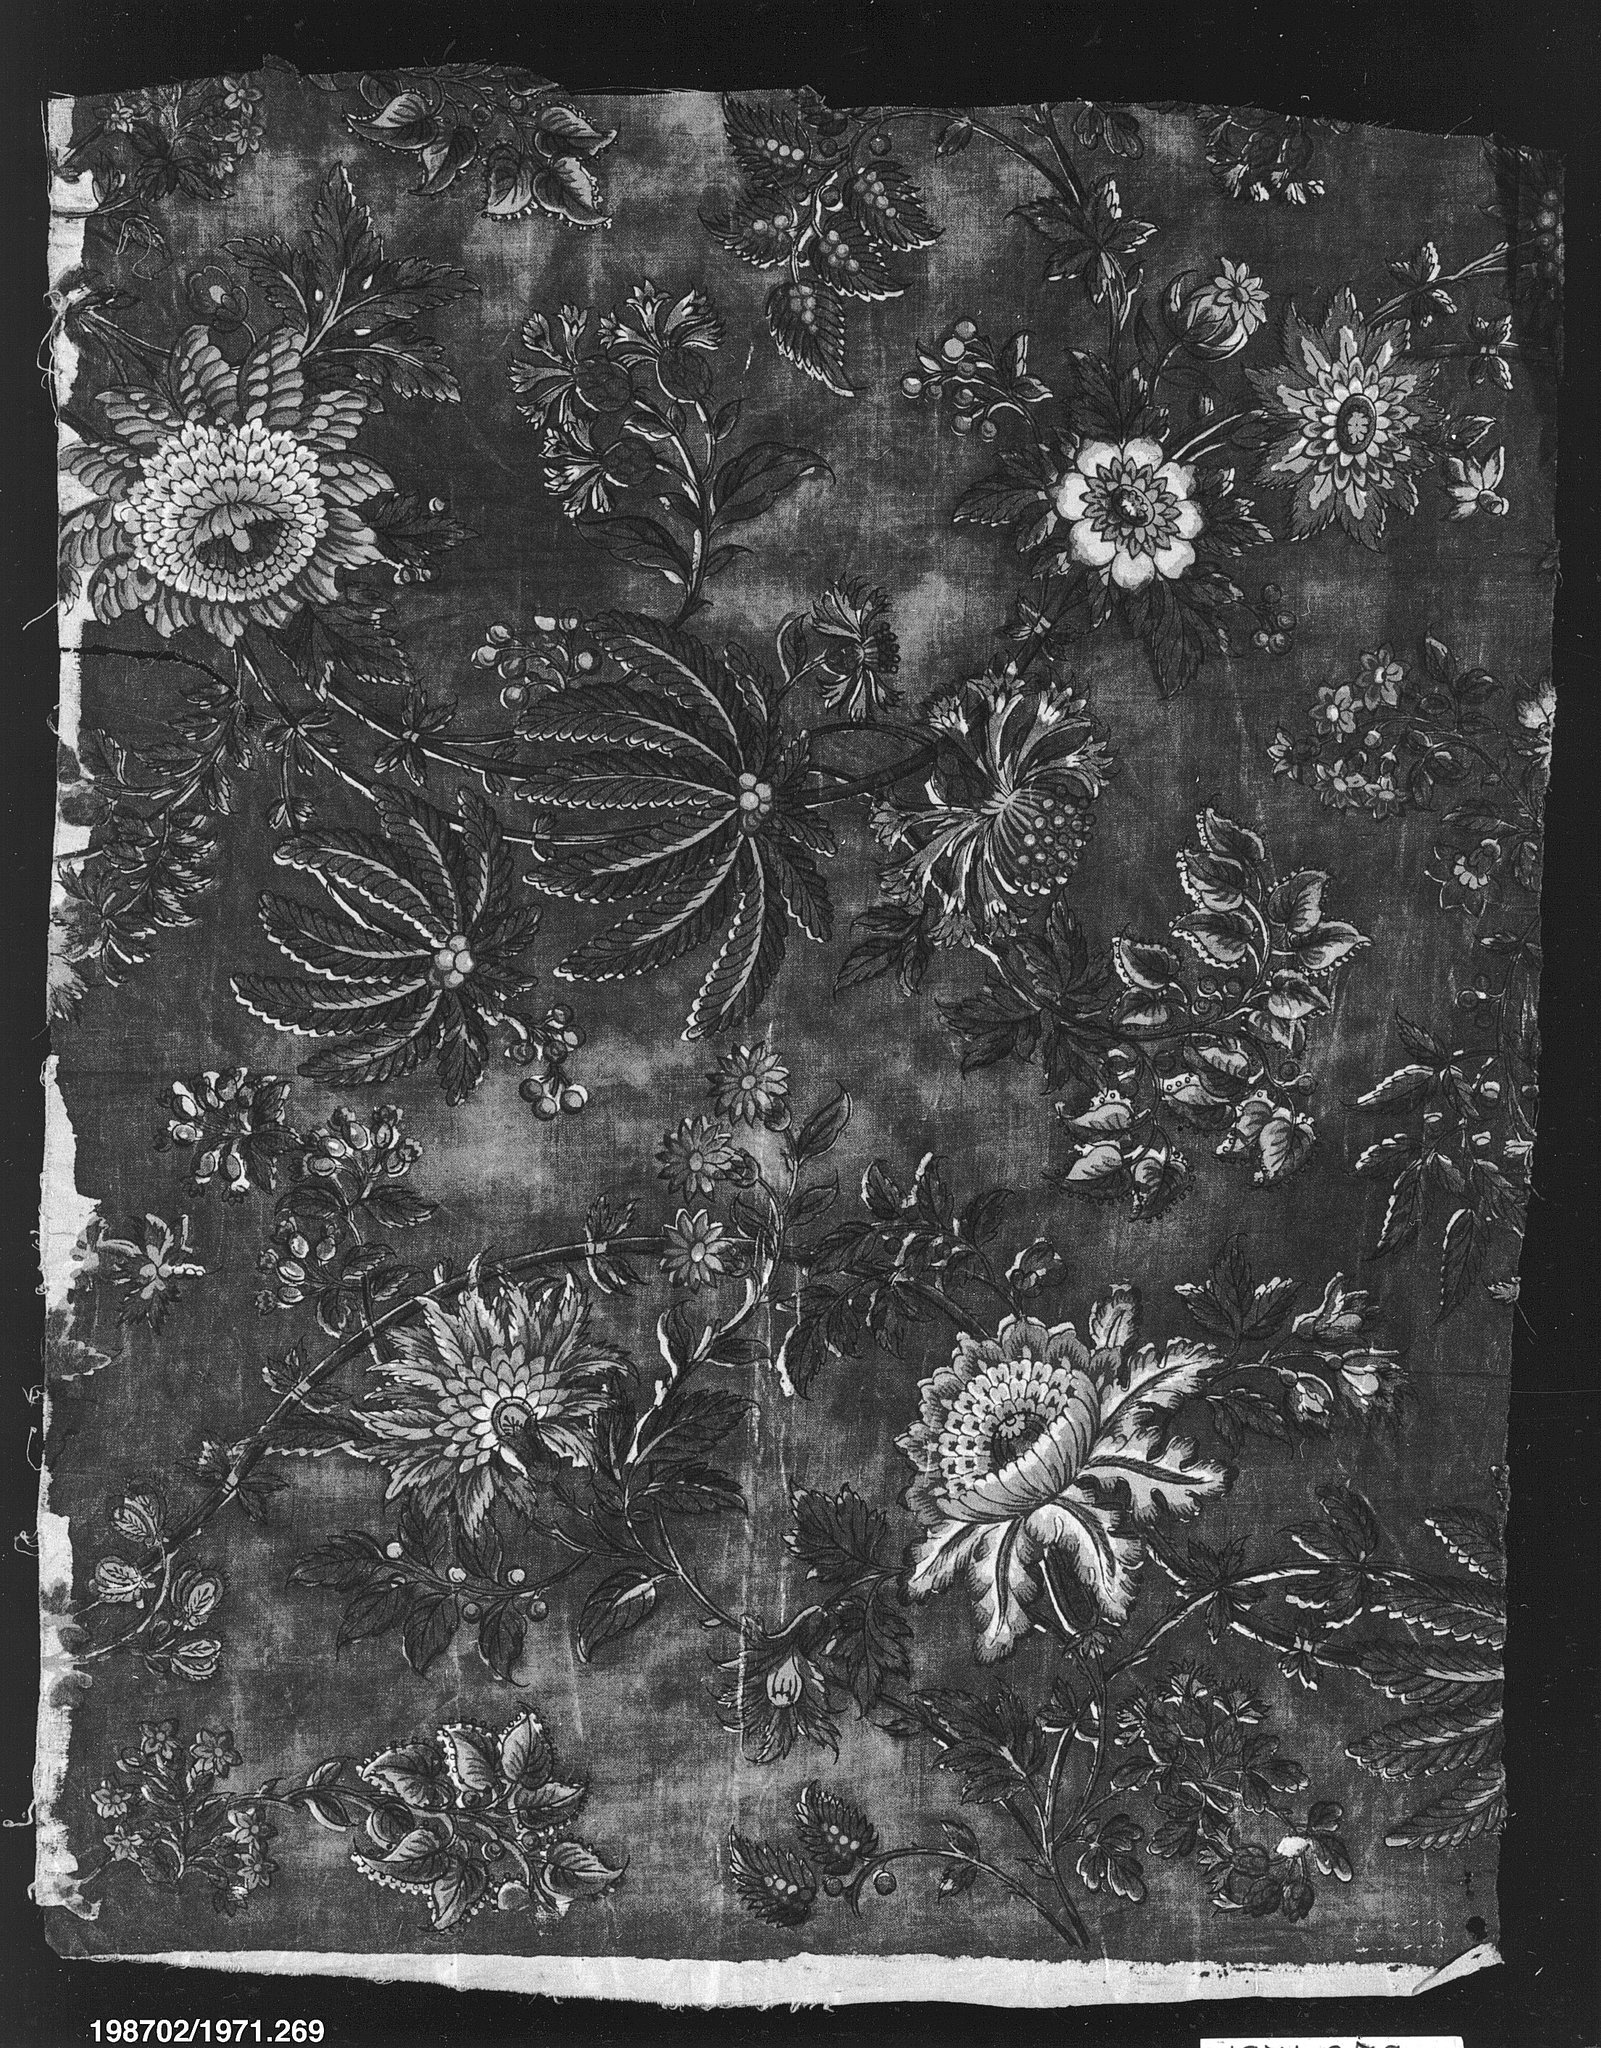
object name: piece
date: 1810-1815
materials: cotton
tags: flowers,leaves